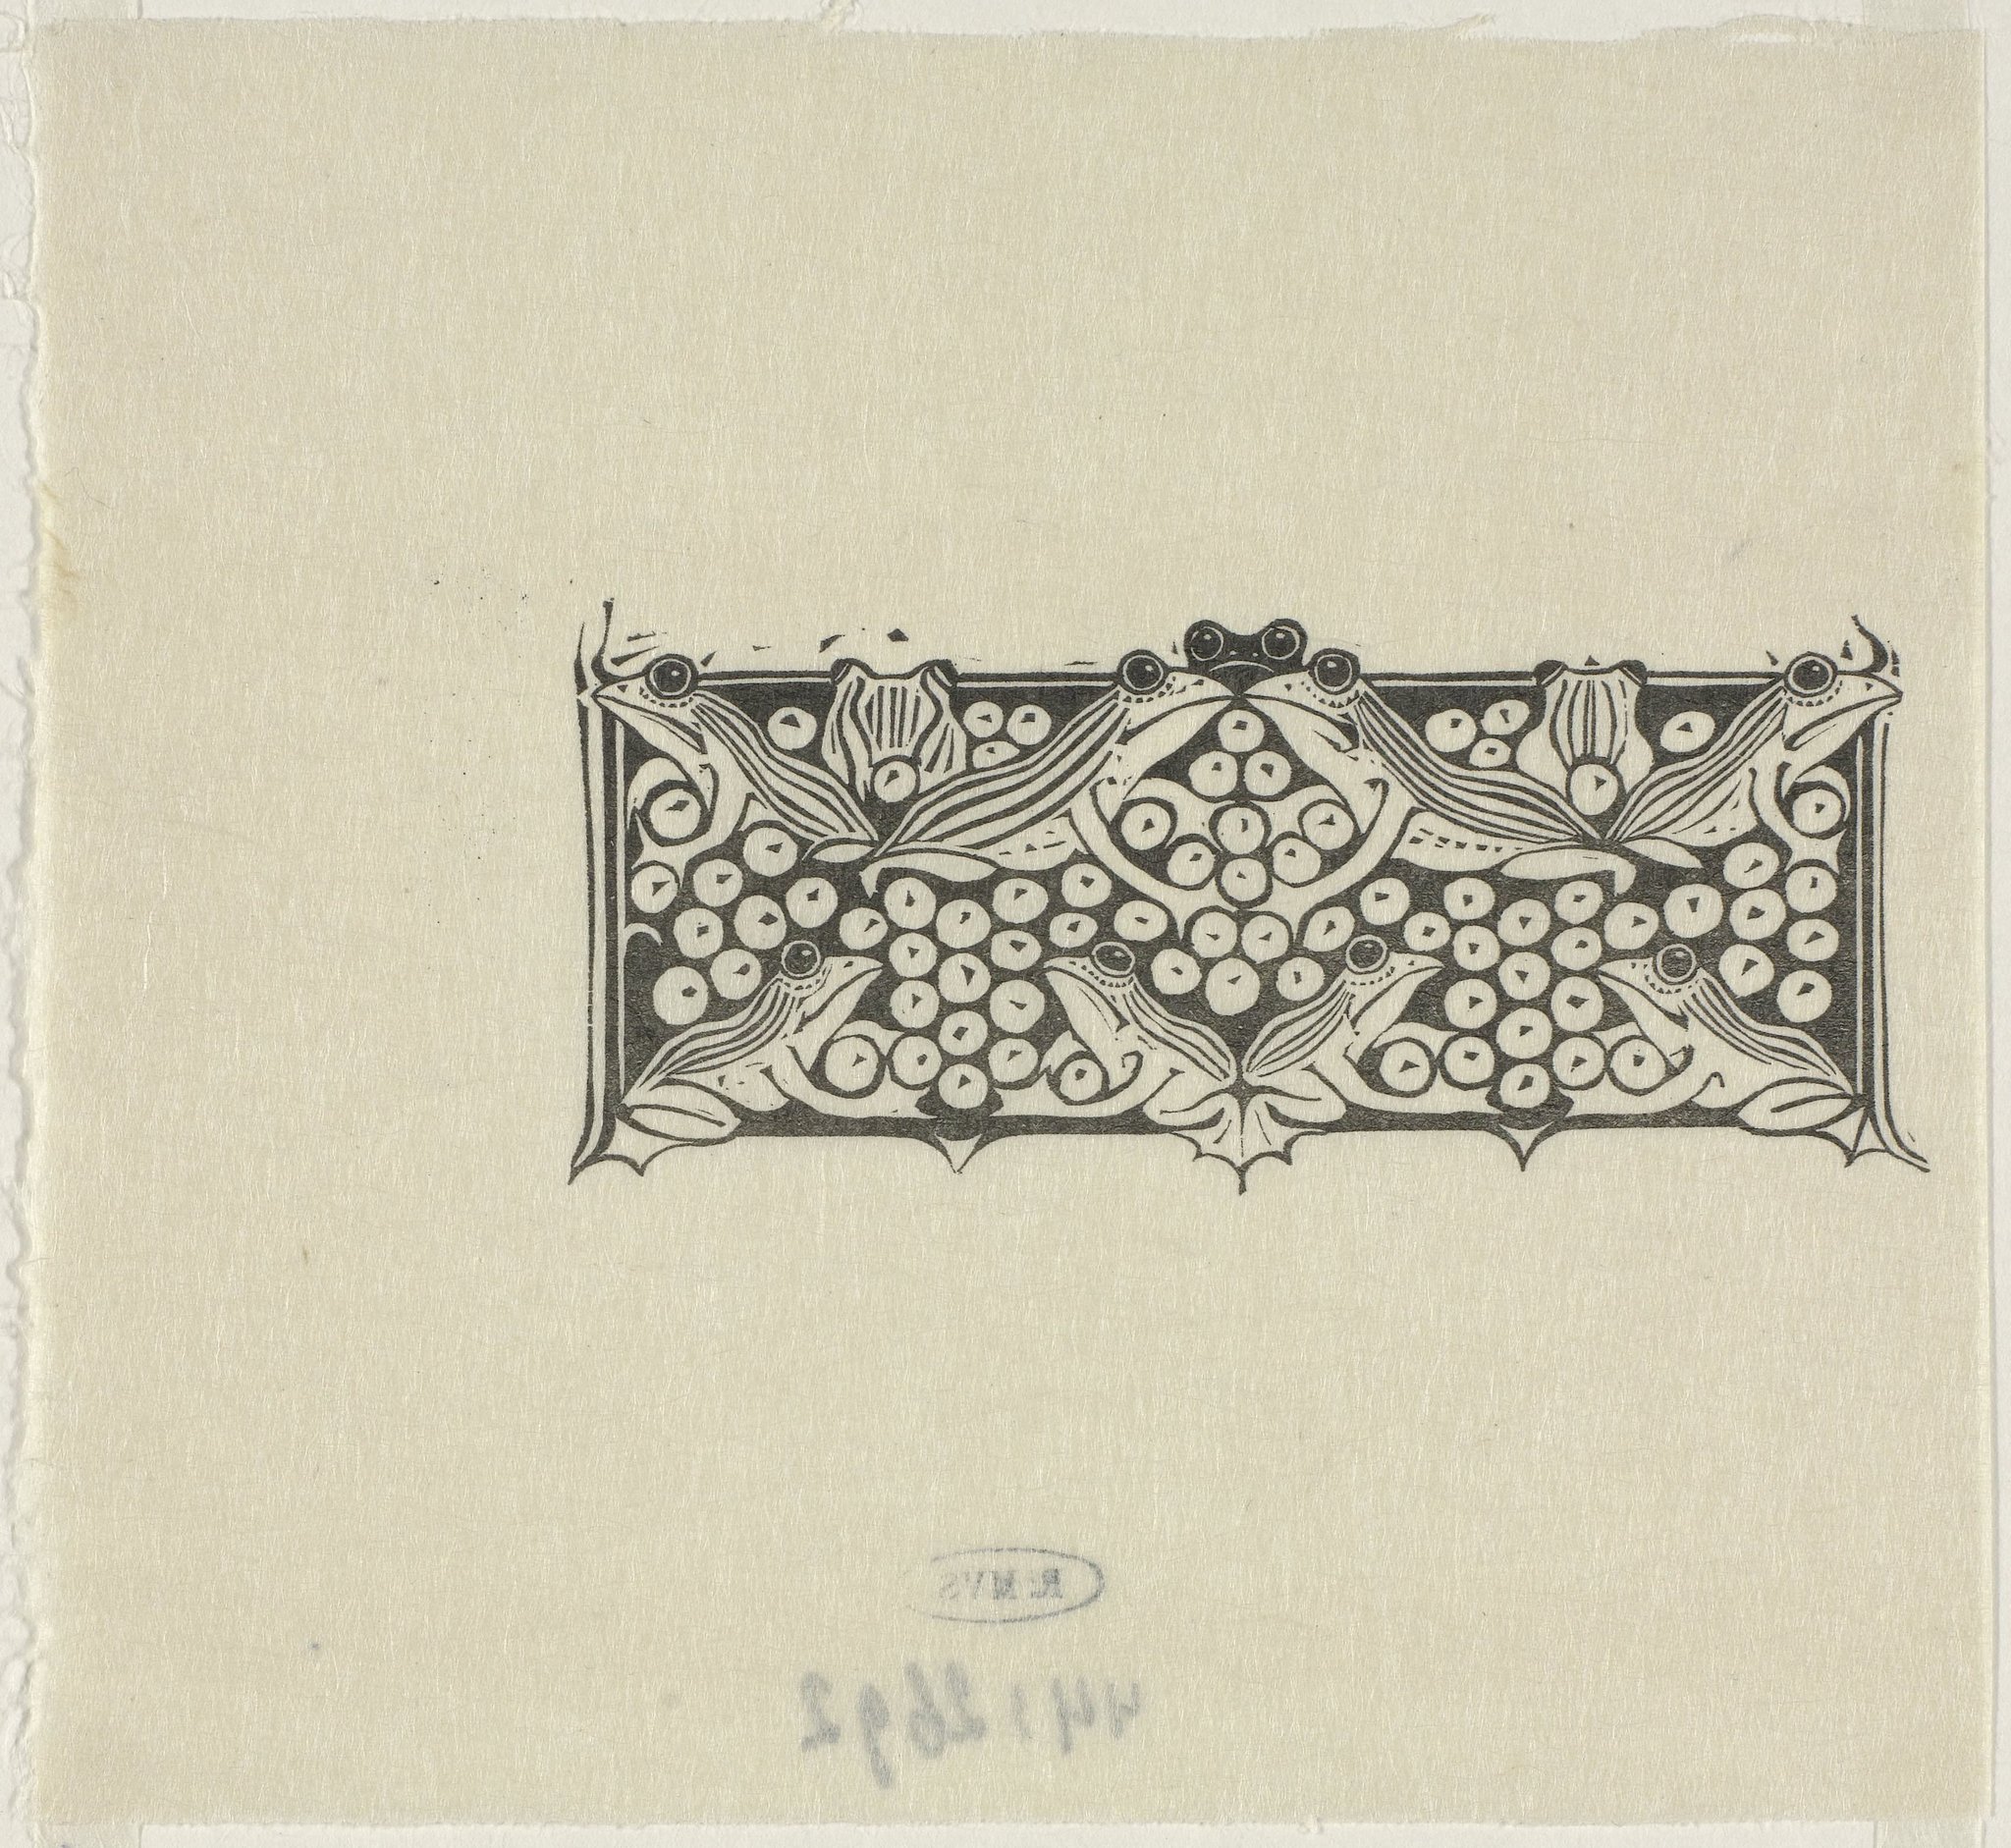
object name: print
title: Titelhoofd met kikkers en kikkerdril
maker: gerrit willem dijsselhof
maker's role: designer, draughtsman, print maker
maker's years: 1866-1924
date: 1893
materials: paper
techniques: woodcut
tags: tailless amphibians: frog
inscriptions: collector's mark: Lugt 2228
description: Deze kikkers worden meermalen gespiegeld weergegeven. Tweemaal vormen ze de letter ‘x’. Dijsselhof vulde de restruimte met kikkerdril. Escher zou zich uitgedaagd hebben gevoeld om hiervoor gelijksoortige vormen te gebruiken. Je zou hier kunnen spreken van een ‘onregelmatige vlakvulling’ (irregular plane filling).